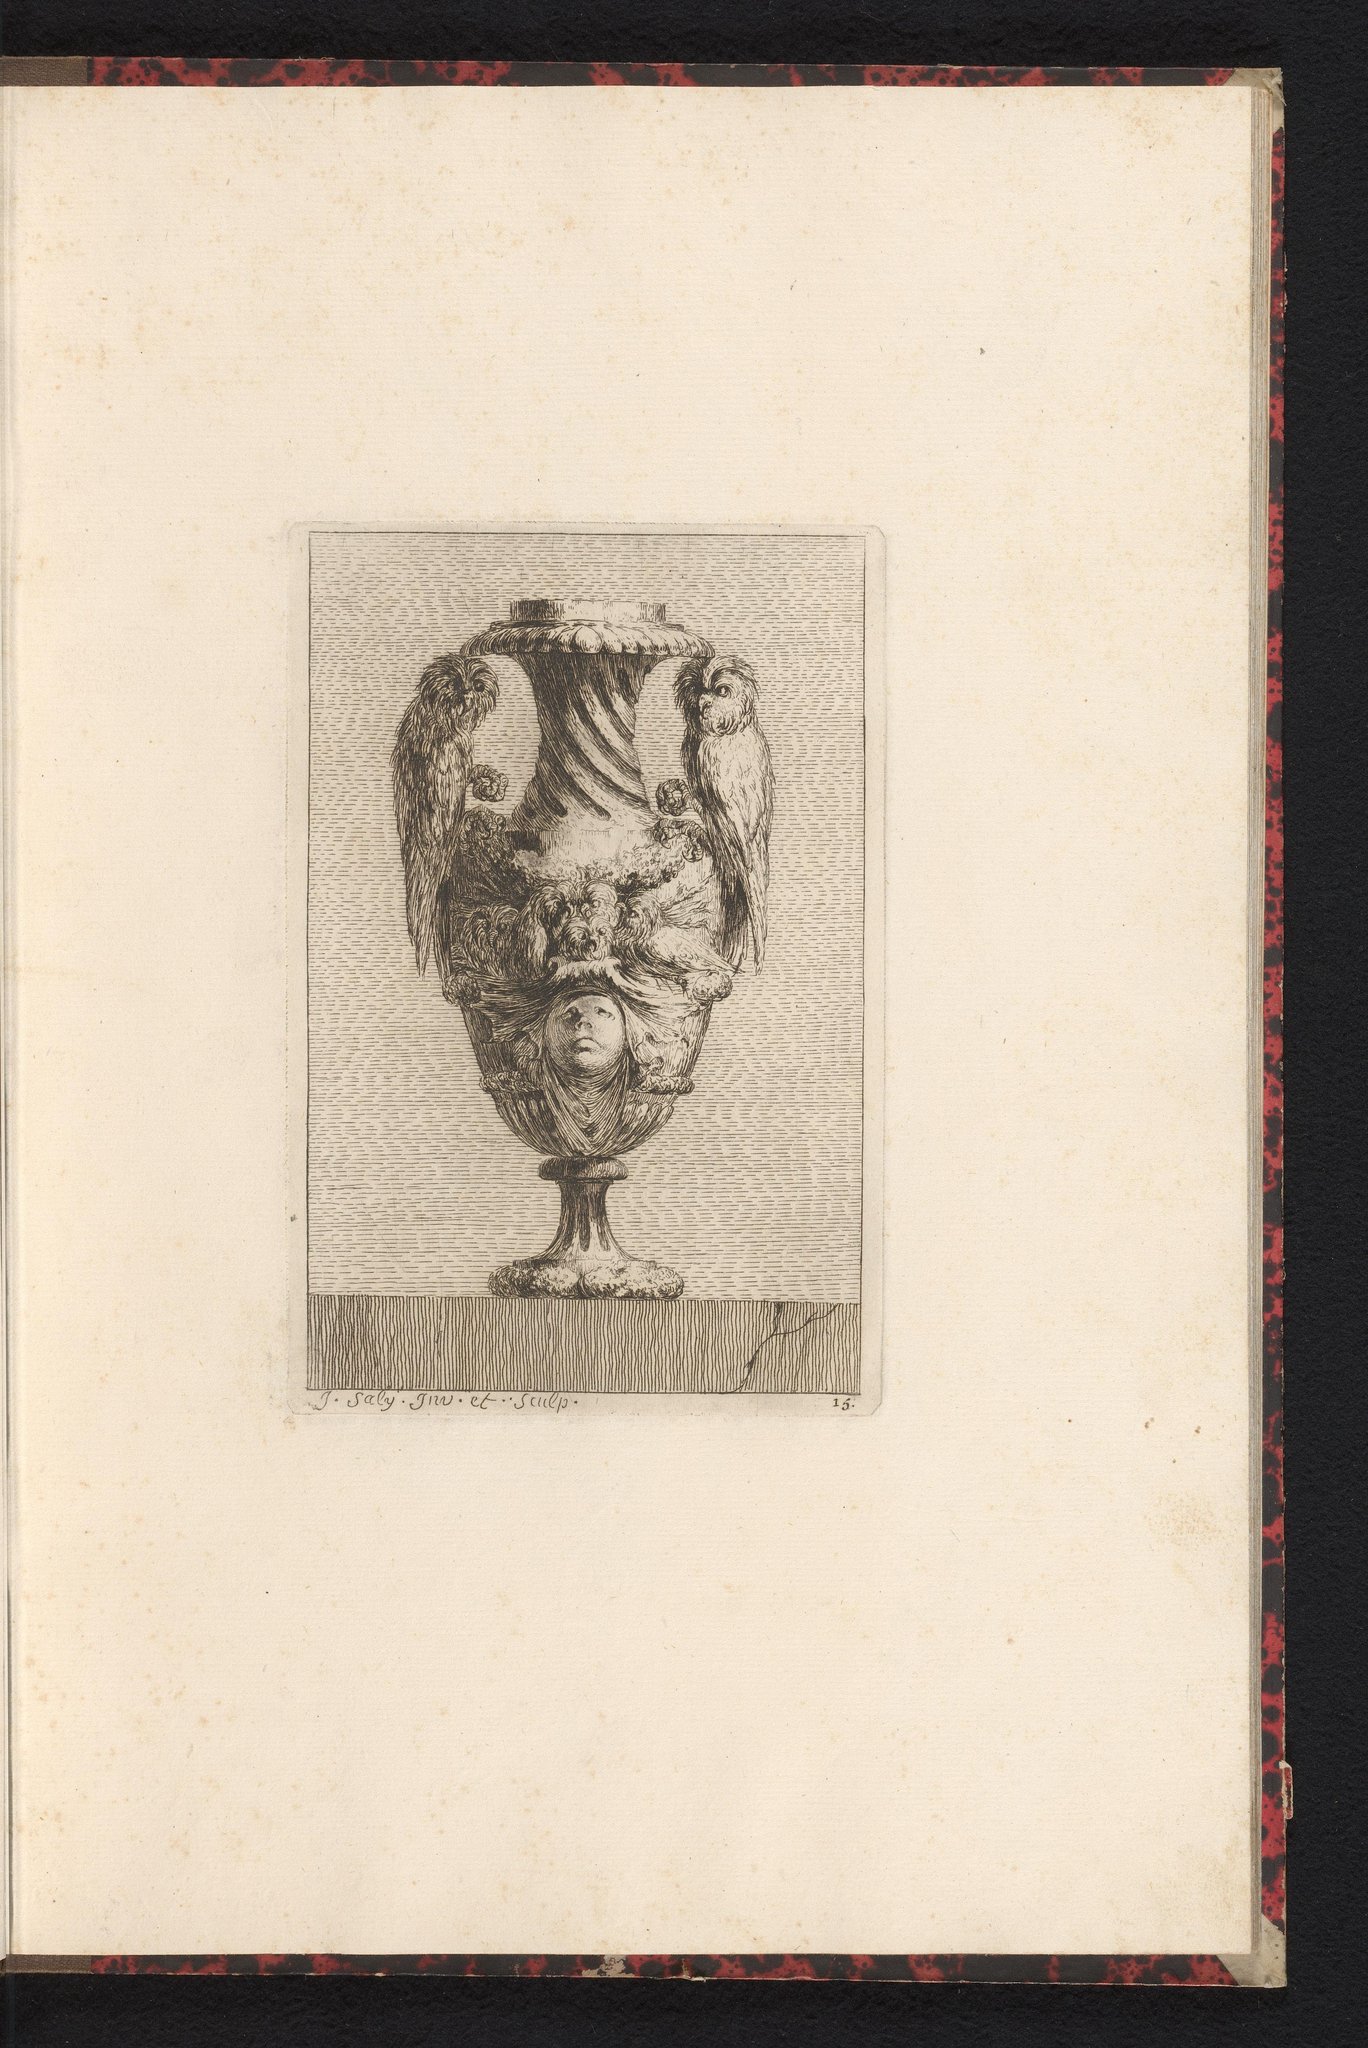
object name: album leaf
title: Vasa a se inventa atq. studii causa delin. et incisa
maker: jacques francois joseph saly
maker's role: print maker, sculptor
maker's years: 1717-1776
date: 1746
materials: paper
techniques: etching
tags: mask, mascaron ~ ornament, owls, garden vase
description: Deze prent maakt deel uit van een album.